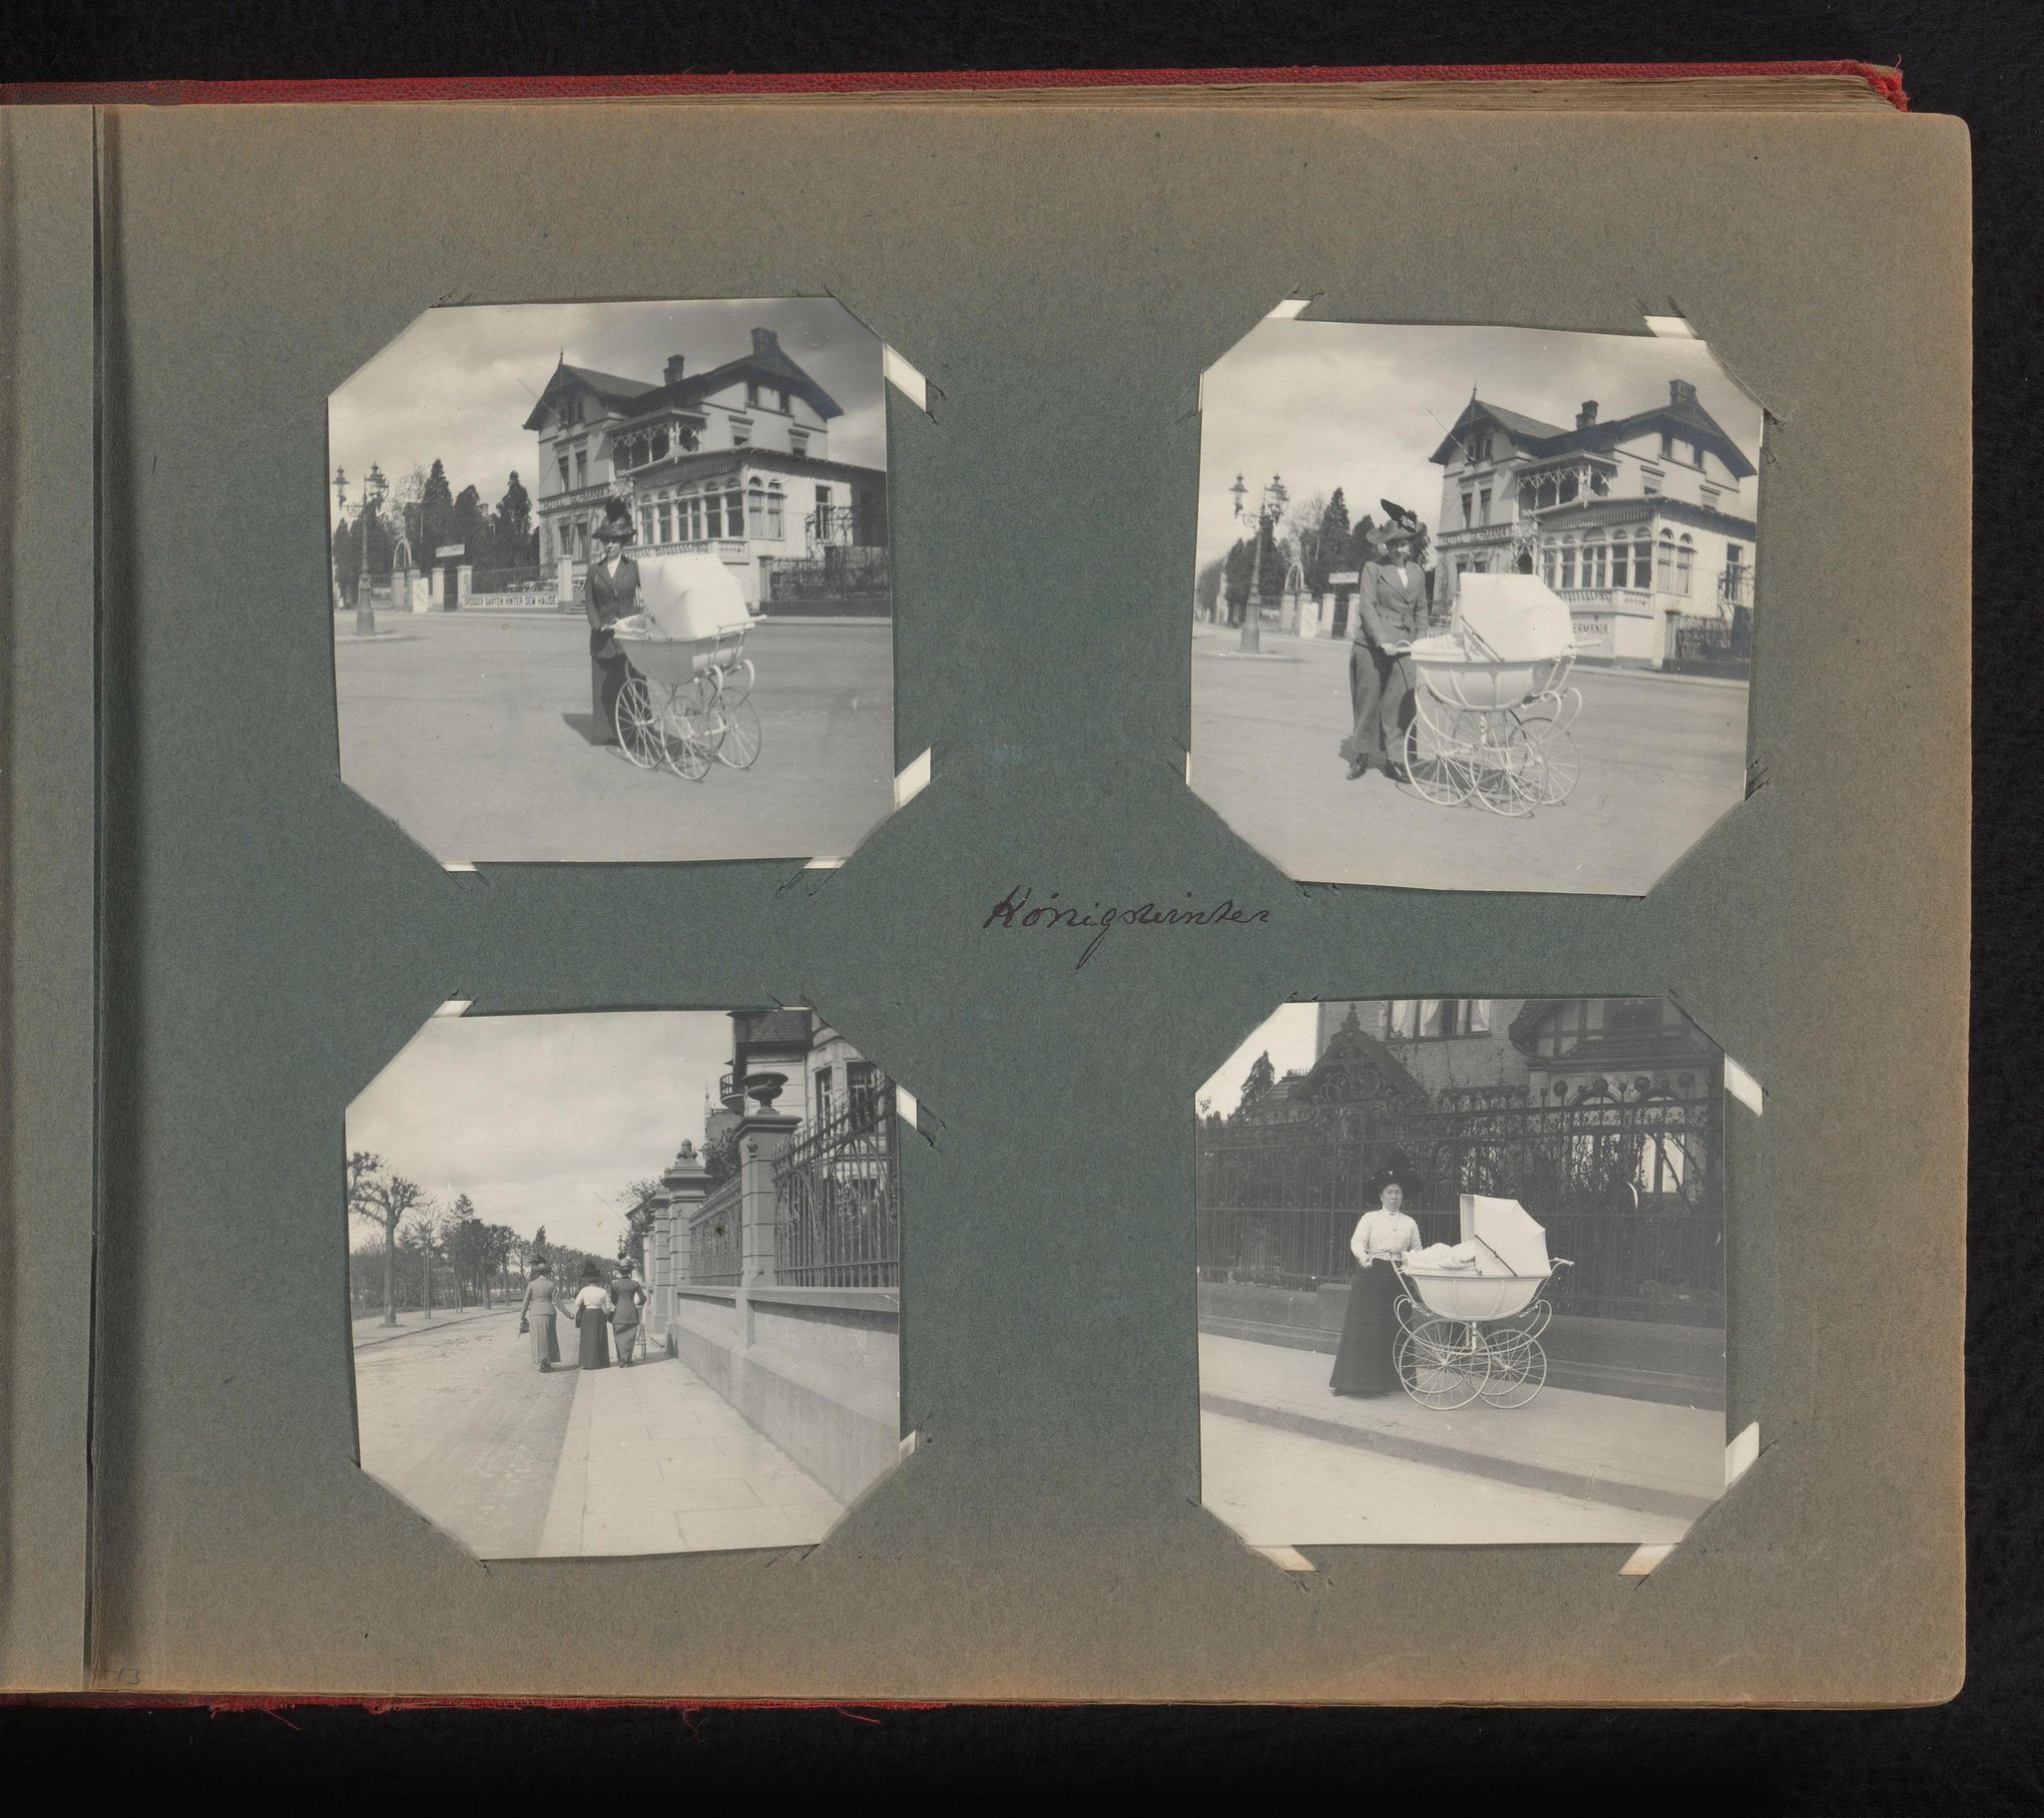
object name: album leaf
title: Königswinter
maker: charlotte alida boelen-matthes (lot)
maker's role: amateurfotograaf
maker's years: 1889-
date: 1912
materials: paper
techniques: gelatin silver print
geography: königswinter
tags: charlotte alida boelen-matthes (lot), baby-carriage, pram, perambulator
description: Deze foto's zijn onderdeel van een album.